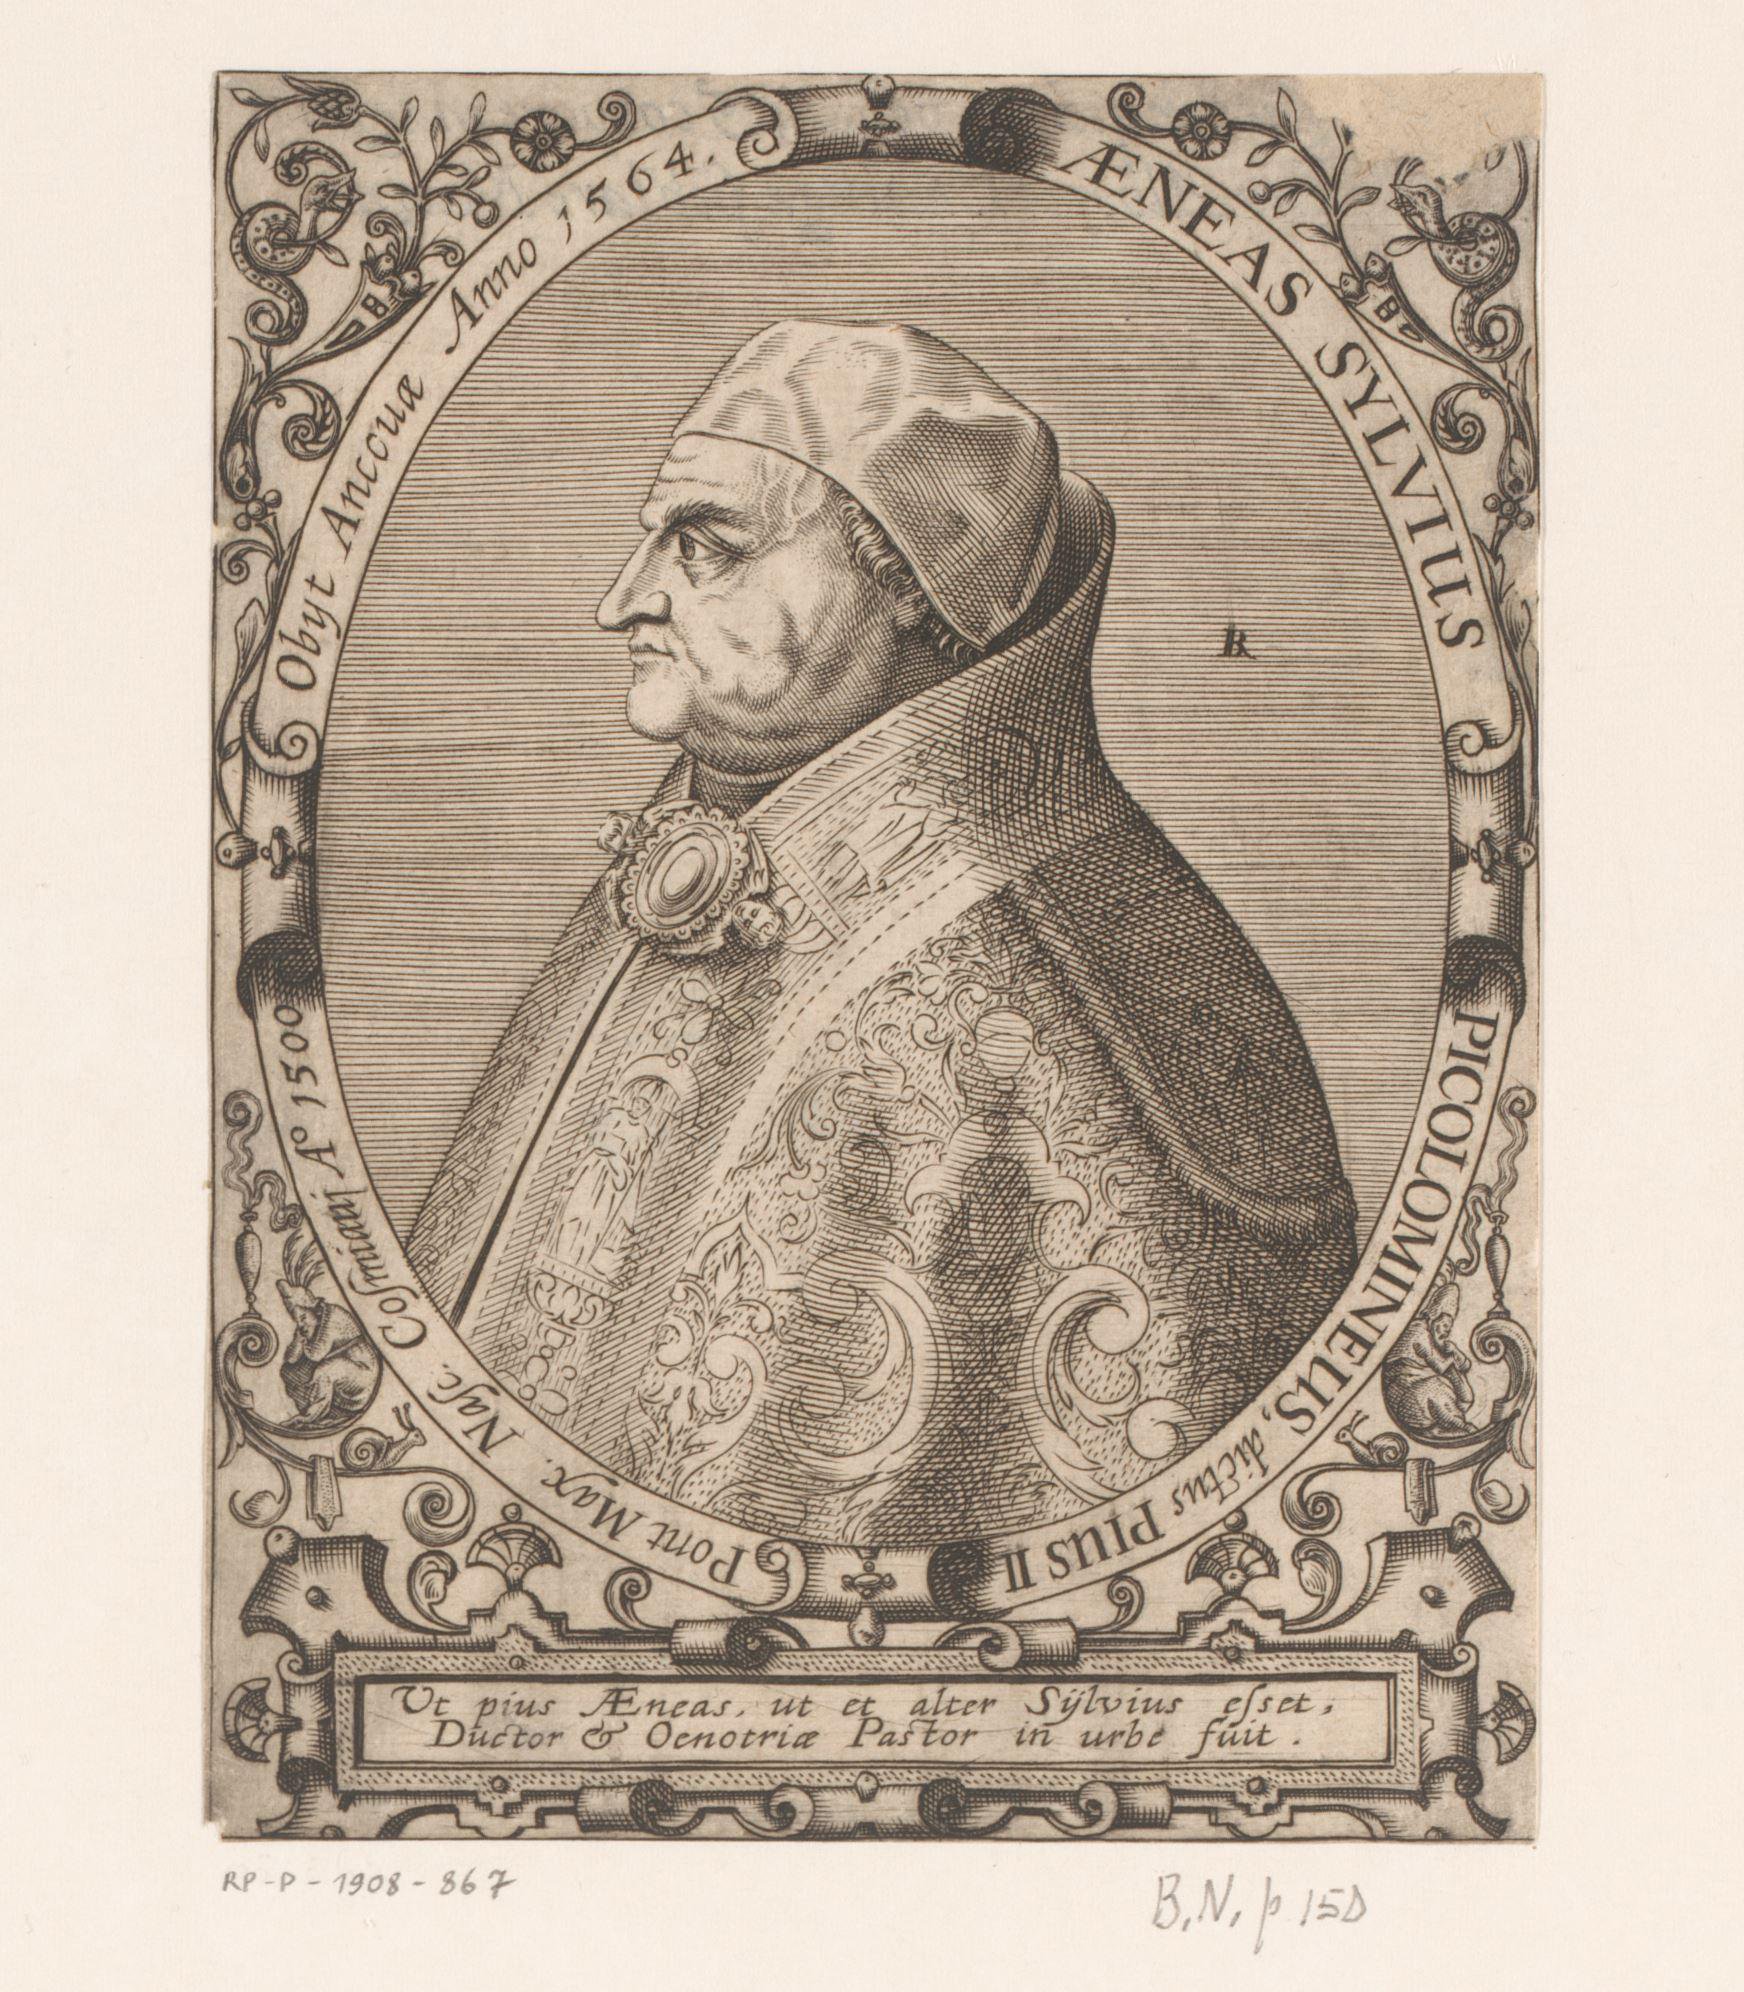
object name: print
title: Serie portretten van vijftiende- en zestiende-eeuwse geleerden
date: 1597-1599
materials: paper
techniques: engraving, letterpress printing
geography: france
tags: rome, molluscs: snail - ff - fabulous animals (sometimes wrongly called 'grotesques'); 'mostri' (ripa), historical persons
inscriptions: collector's mark: Lugt 2228